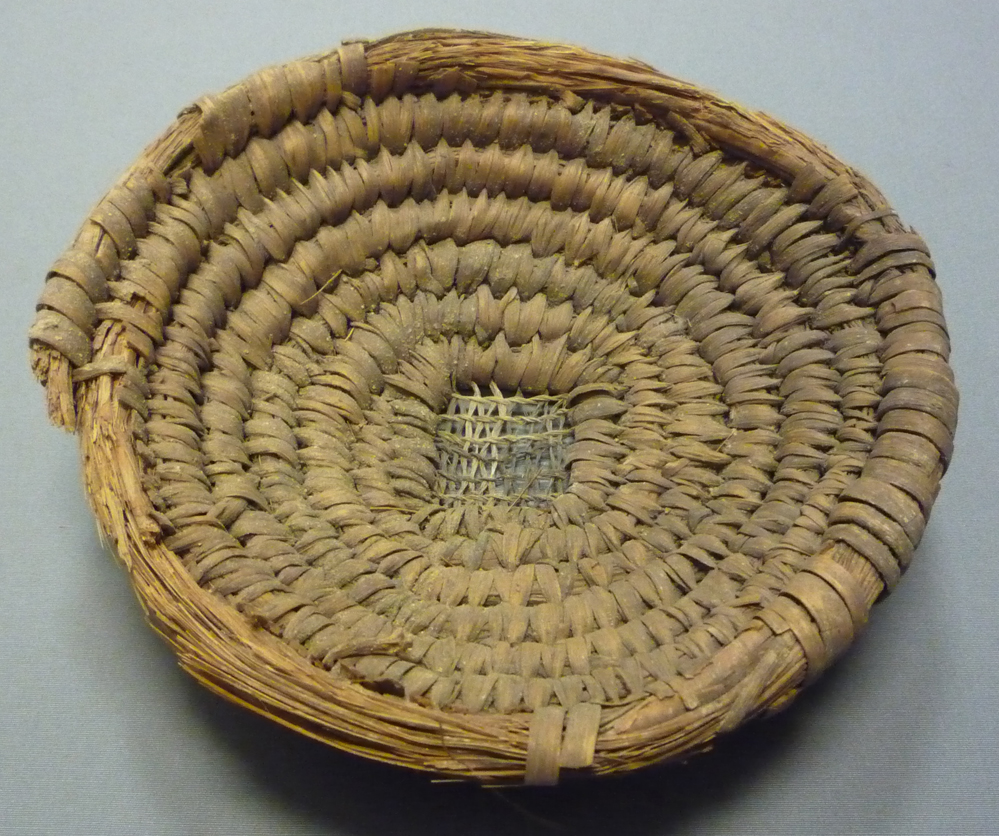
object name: basket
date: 1550-1295 BCE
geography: egypt